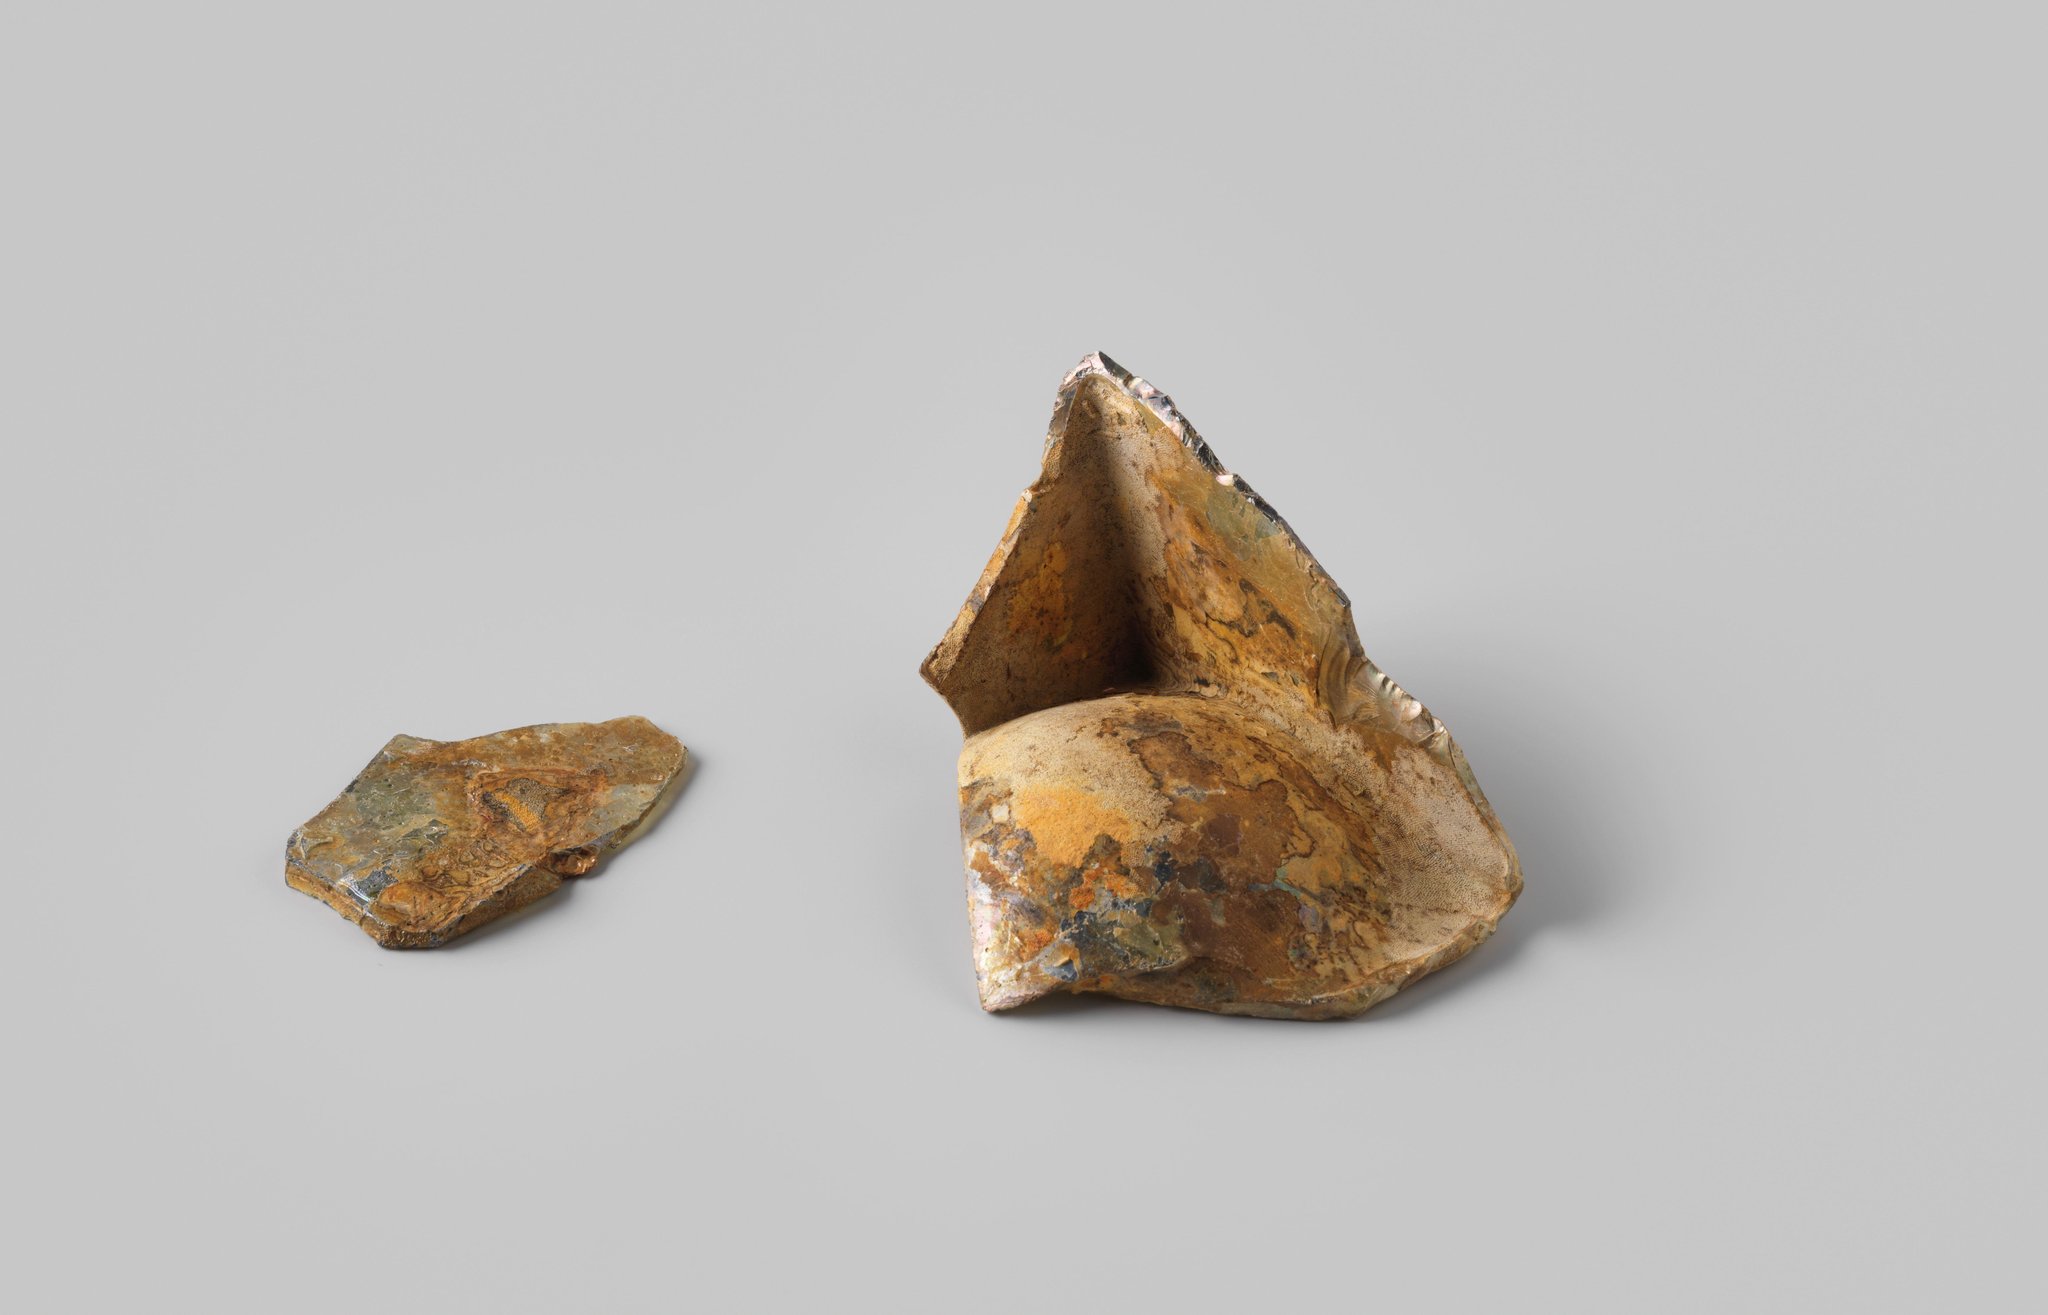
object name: case bottle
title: Scherven van kelderflessen uit het wrak van de Oost-Indiëvaarder 't Vliegend Hart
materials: glass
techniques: green glass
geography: middelburg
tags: 't vliegend hart (schip), verenigde oostindische compagnie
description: Twee fragmenten van vierkante kelderflessen. Eén is een hoek van de bodem met de buik, groengelig bruin van kleur. Het andere is een scherf van de buik en groengeel van kleur. Case bottle.